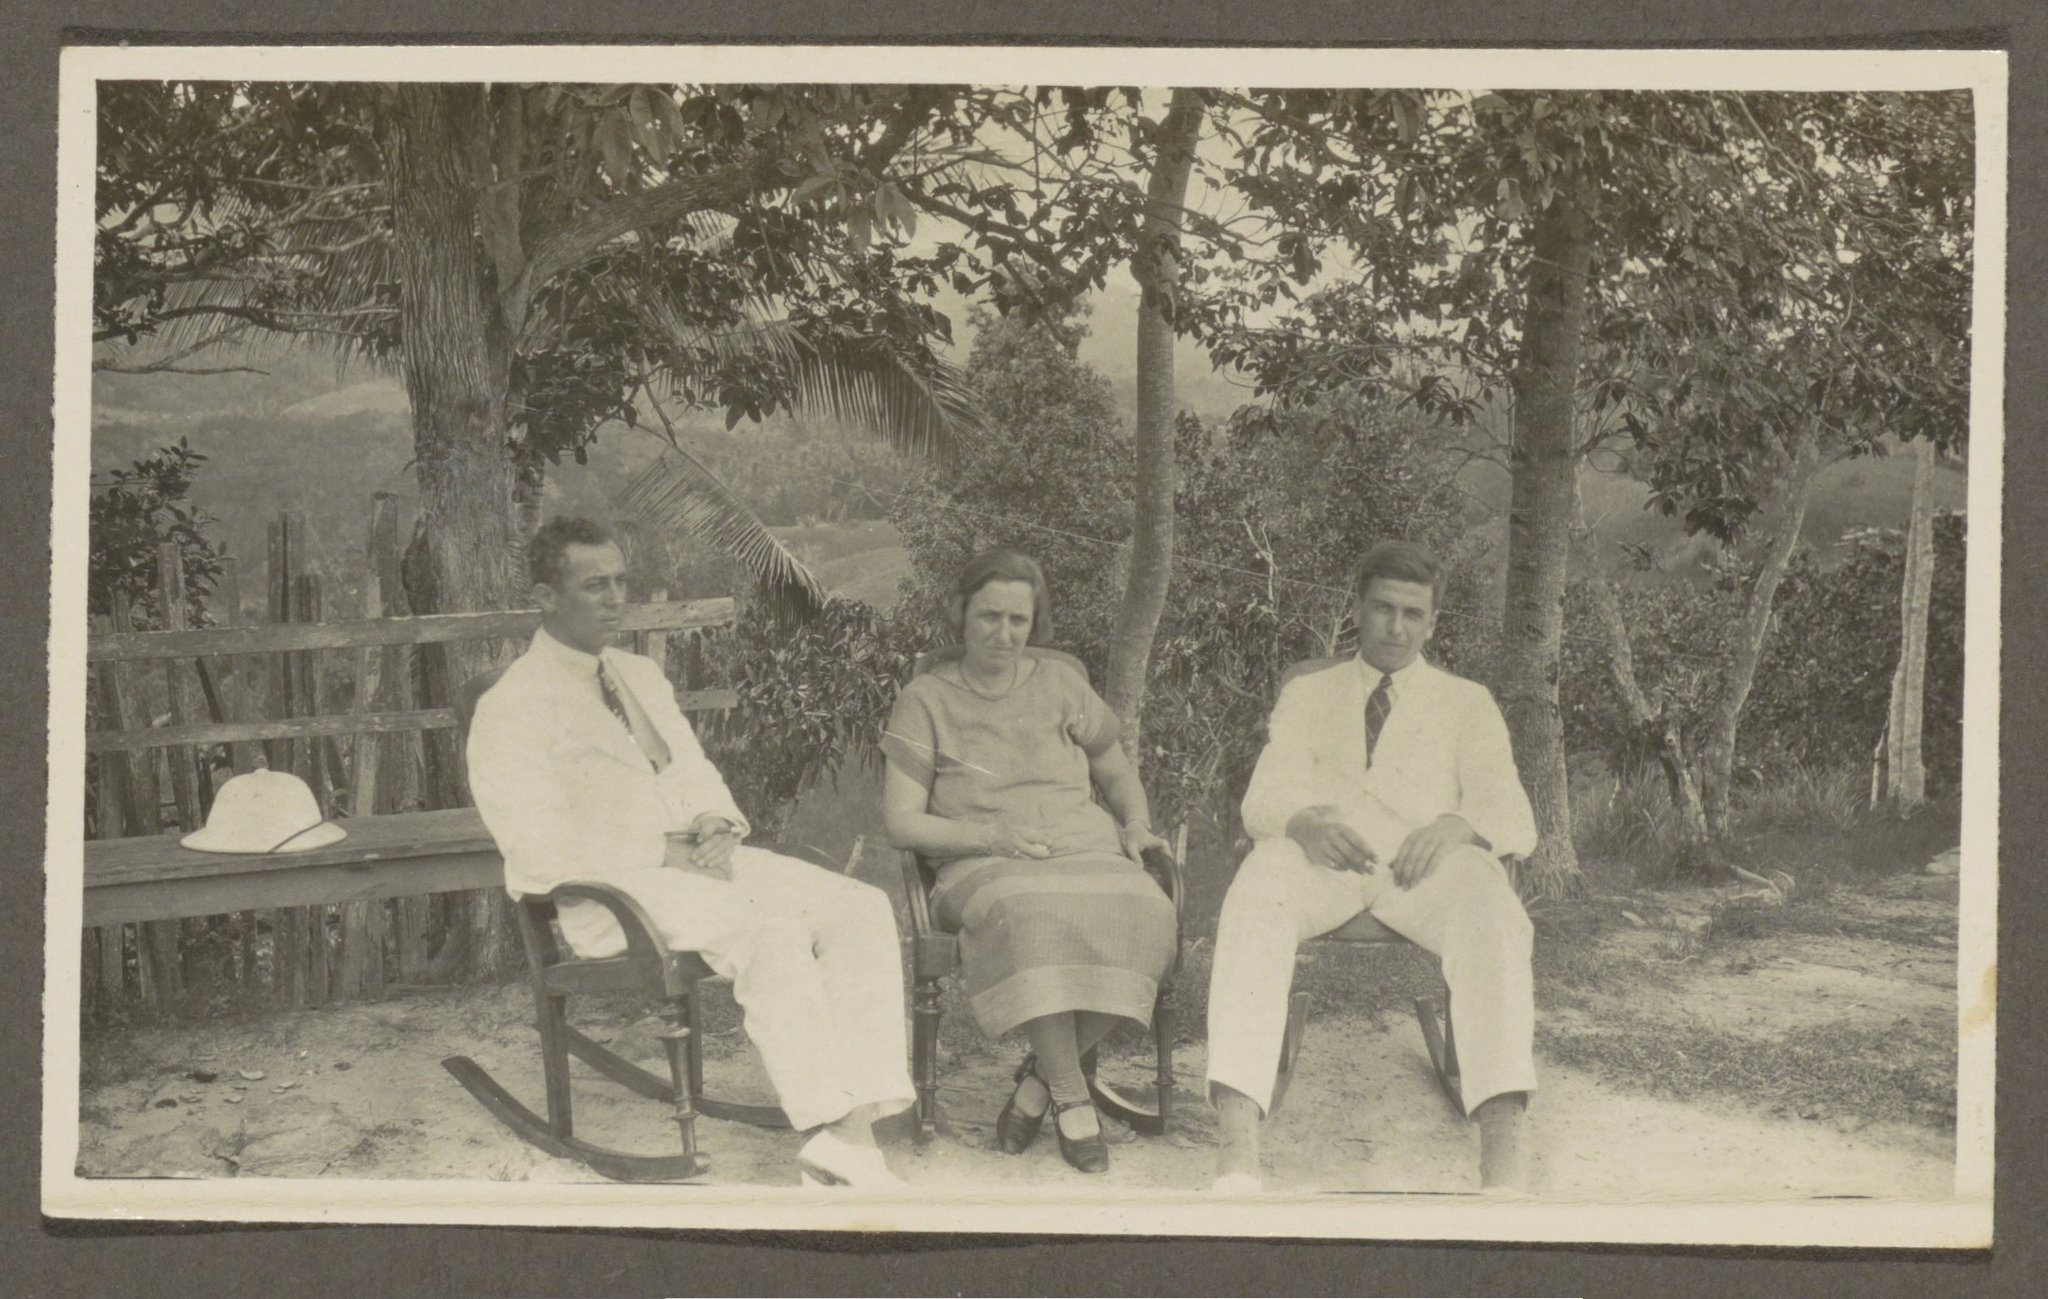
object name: photograph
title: Twee mannen in tropenkleding en een vrouw, zittend op schommelstoelen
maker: Anonymous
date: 1920-1930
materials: photographic support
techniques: gelatin silver print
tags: rocking-chair (+ wood and other phytogenic material), dutch east indies, the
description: Onderdeel van familiealbum Nederlands-Indië.